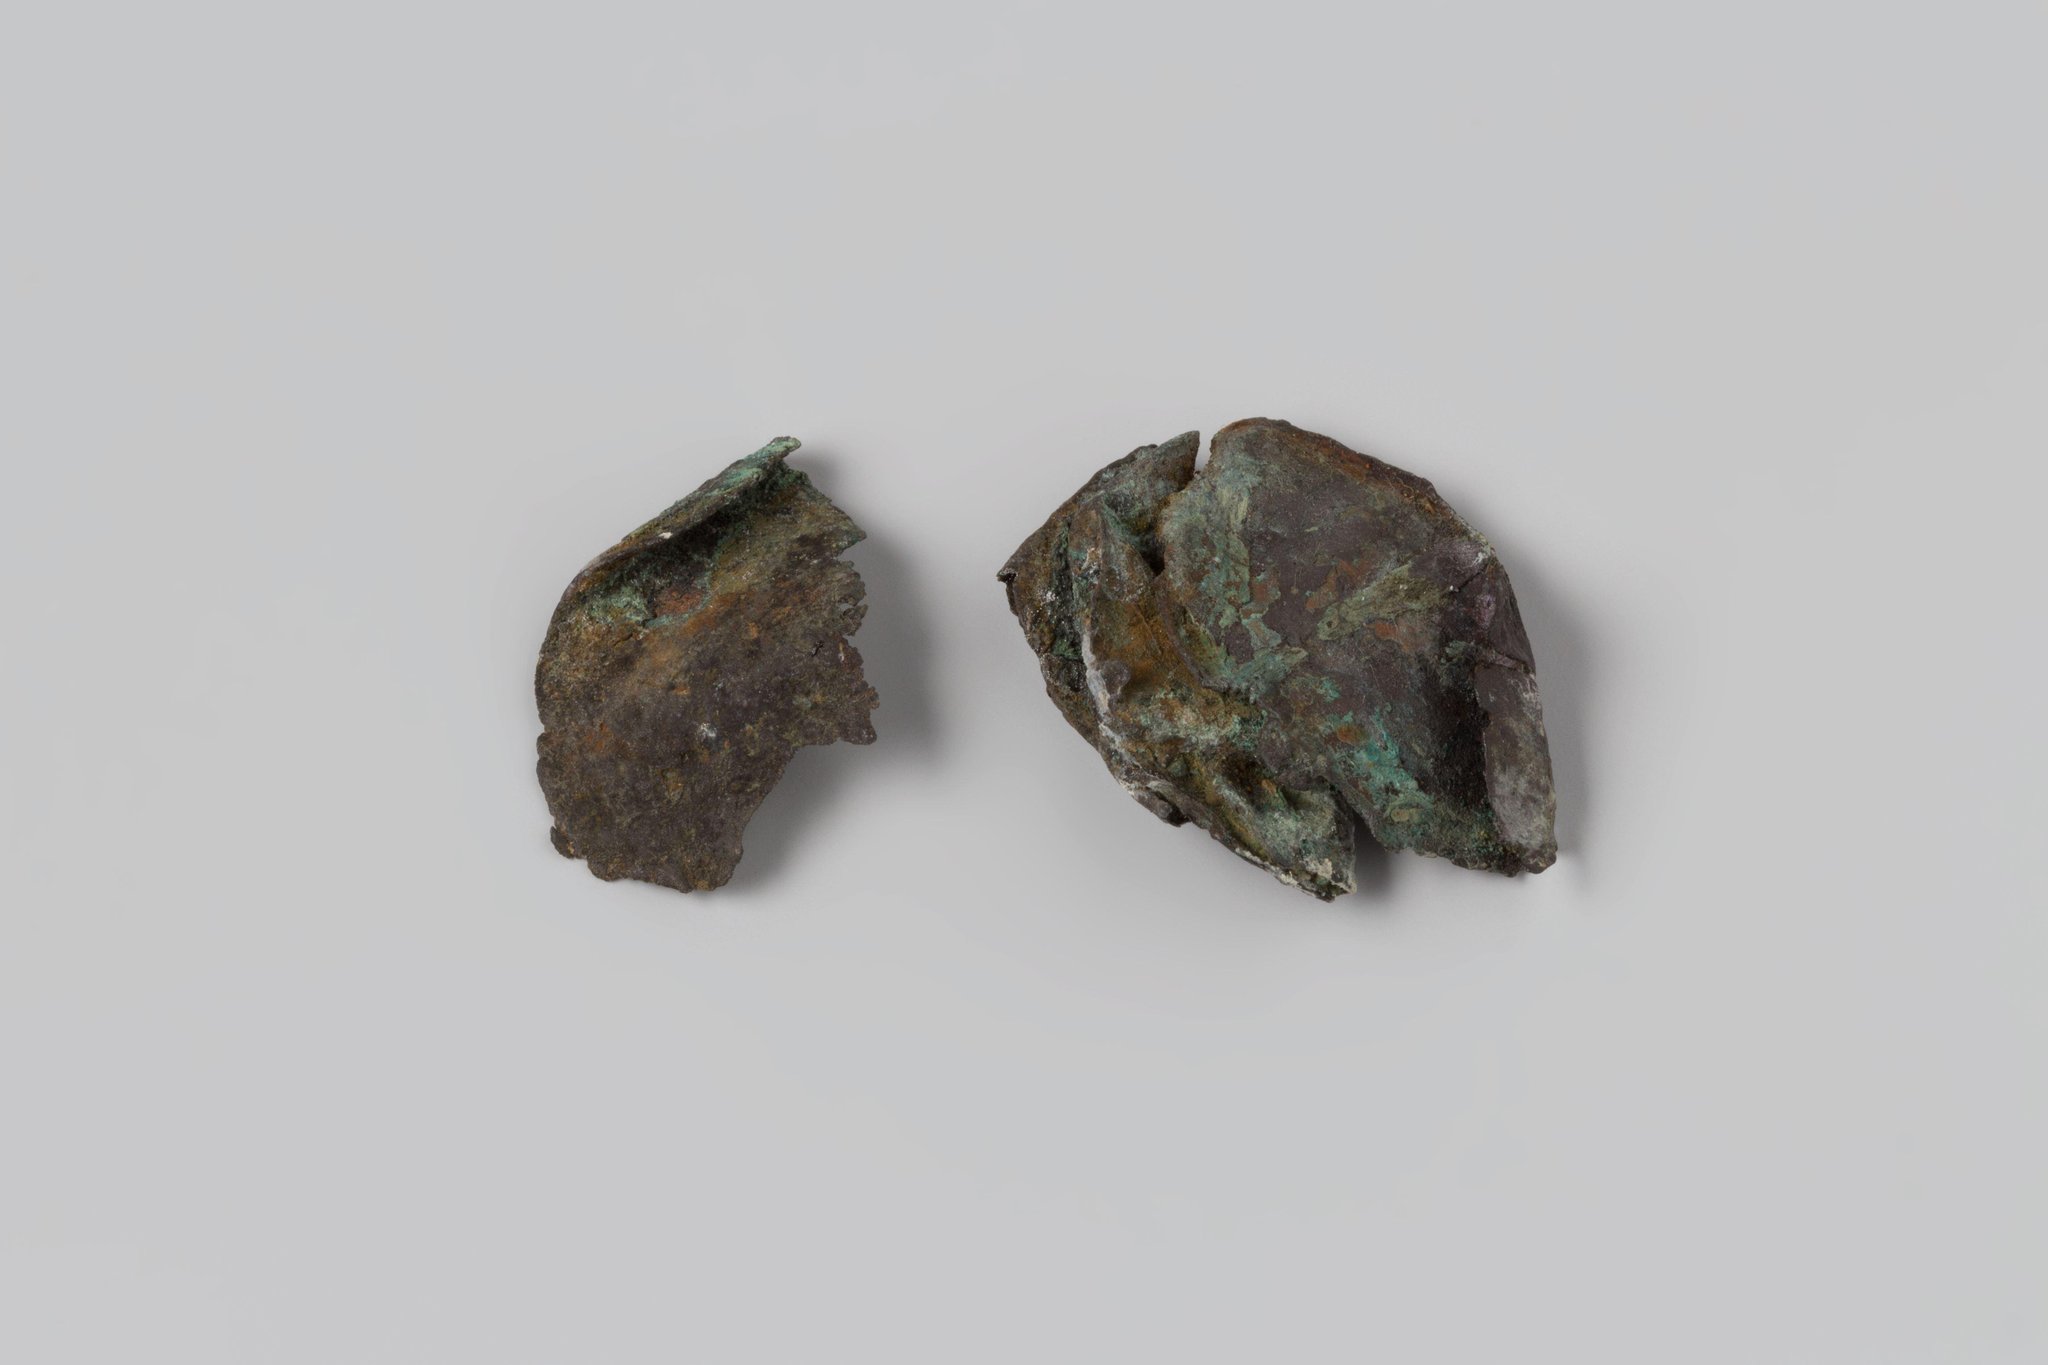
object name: scheepswrakvondst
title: Fragmenten van koper uit het wrak van de Oost-Indiëvaarder Hollandia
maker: Anonymous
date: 1700-1743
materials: copper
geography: netherlands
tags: verenigde oostindische compagnie, hollandia (schip), annet